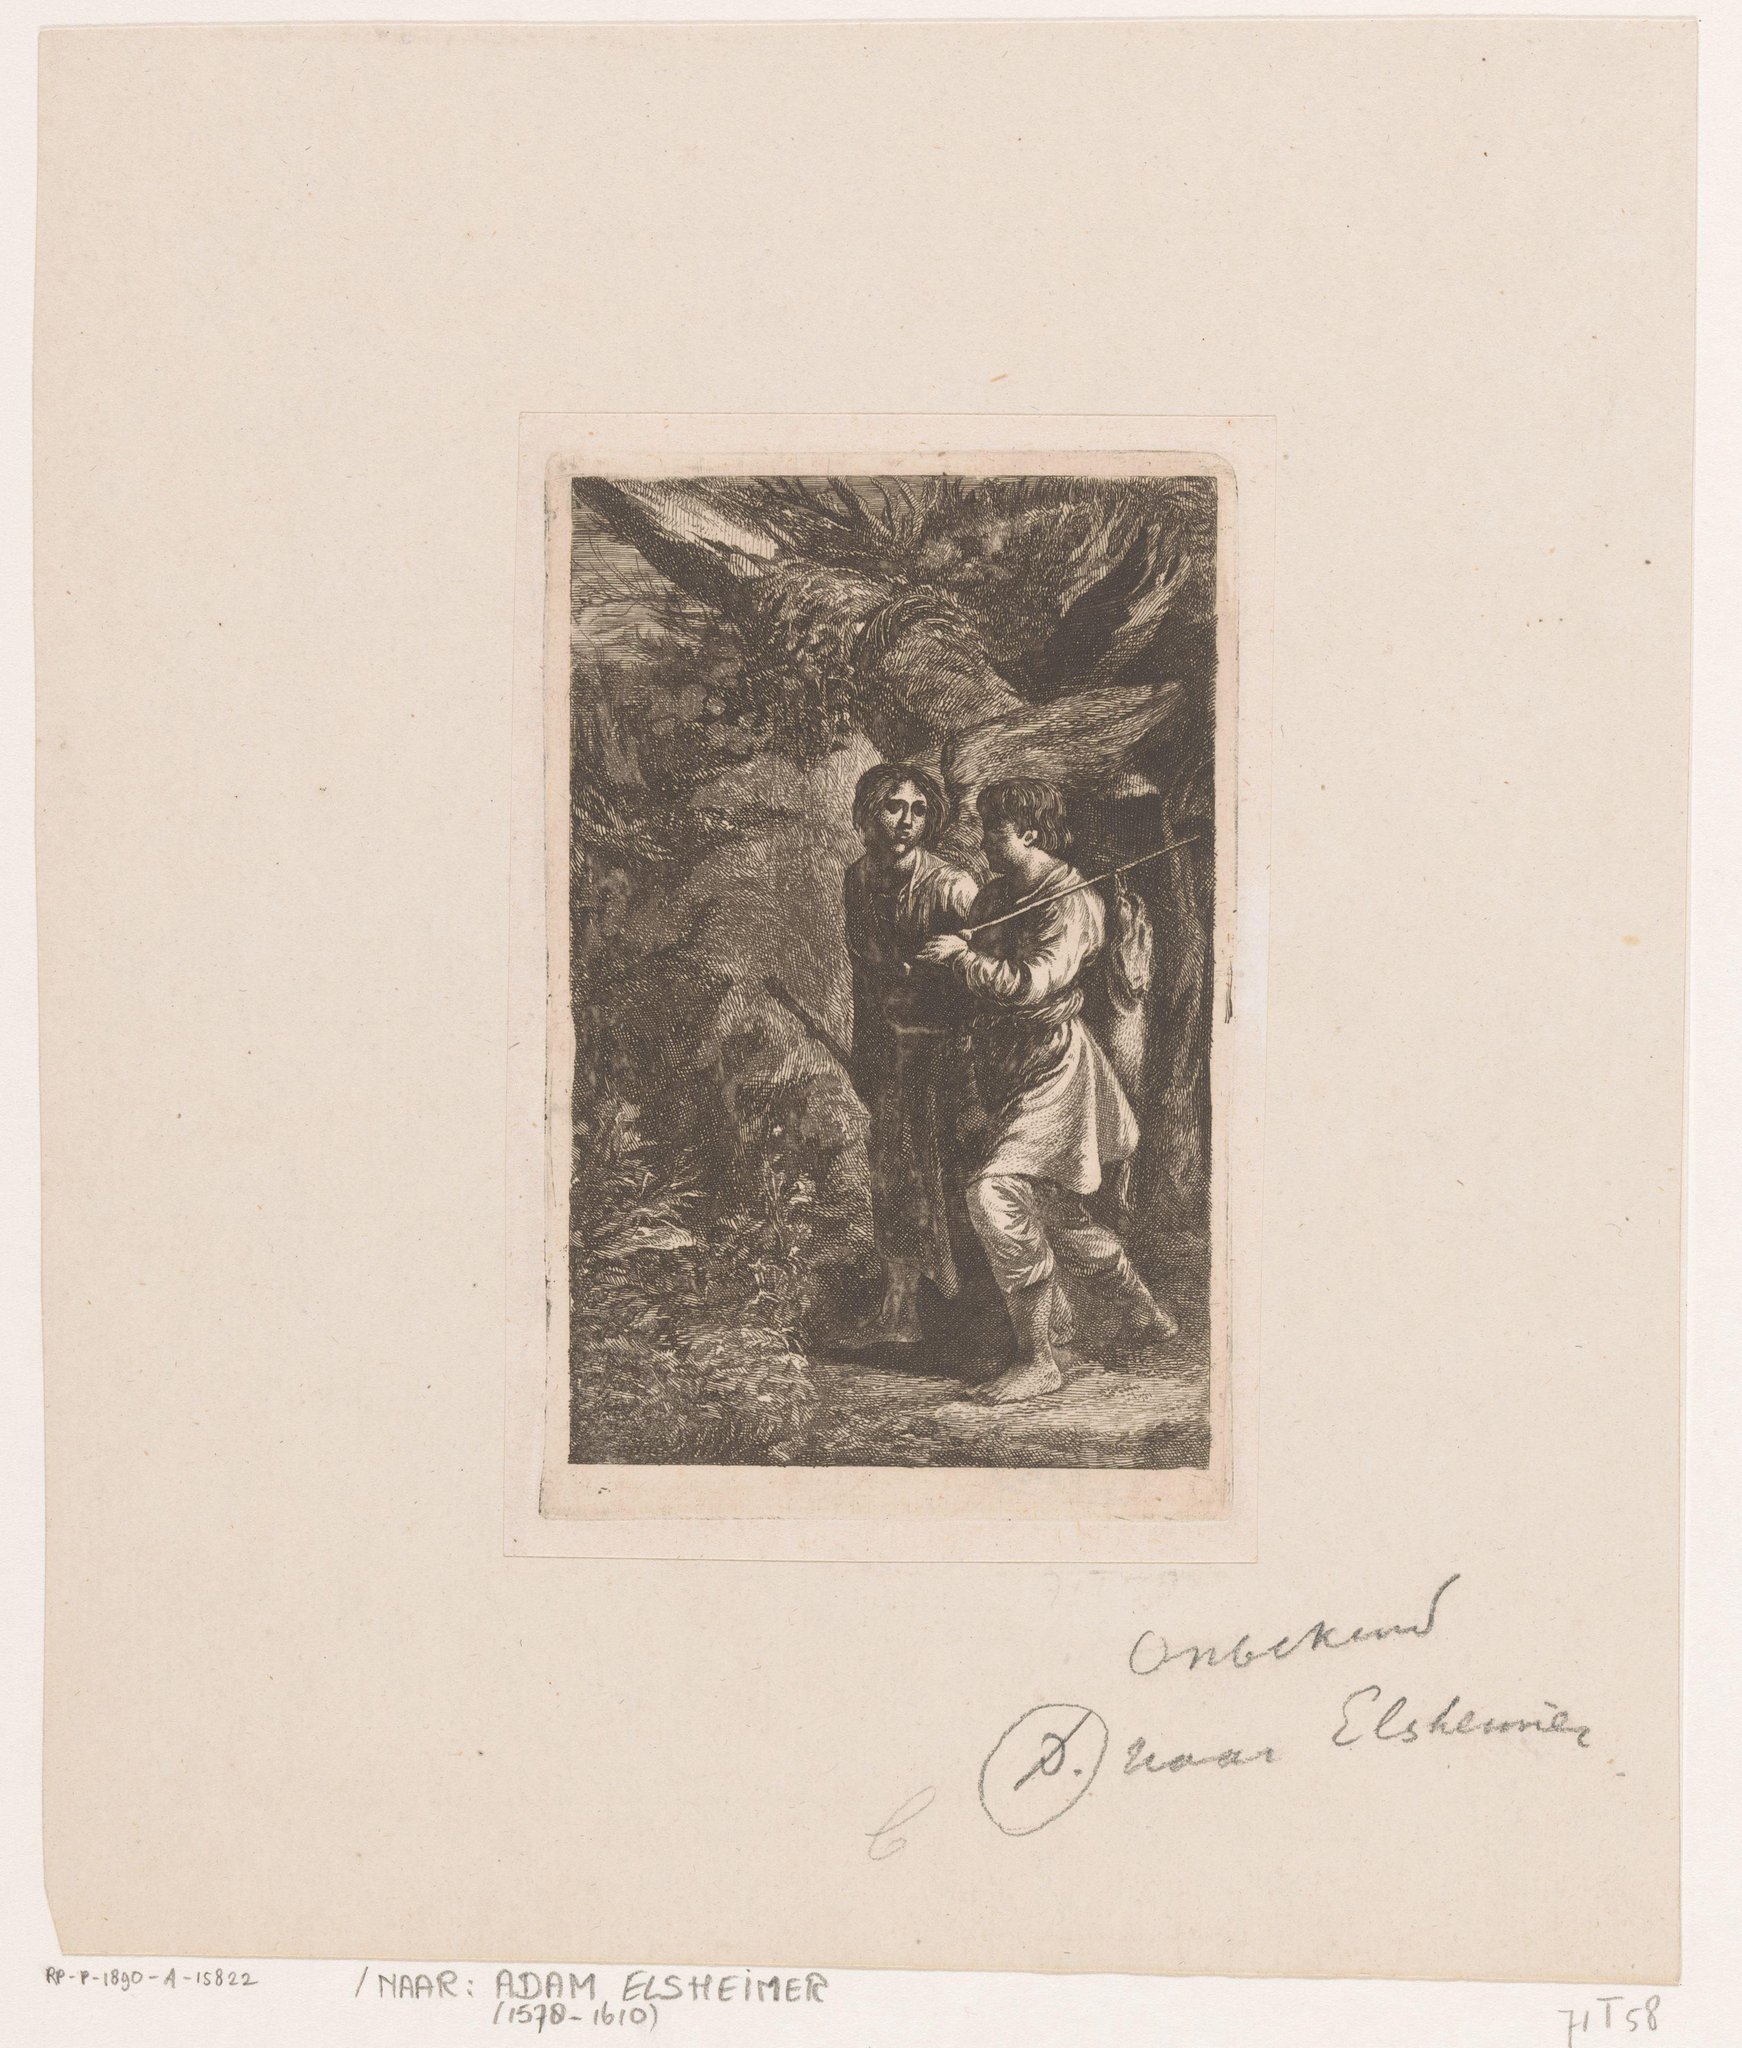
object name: print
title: Tobias en de engel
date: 1600-1699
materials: paper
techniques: etching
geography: germany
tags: tobias and the angel raphael travelling, accompanied by tobias' dog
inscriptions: collector's mark: Lugt 2228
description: Tobias houdt zijn staf, die hij in de linkerhand heeft en waaraan de vis hangt, over zijn schouder. De engel houdt zijn staf in de rechterhand. Achter hem een boom en links op de voorgrond struiken.